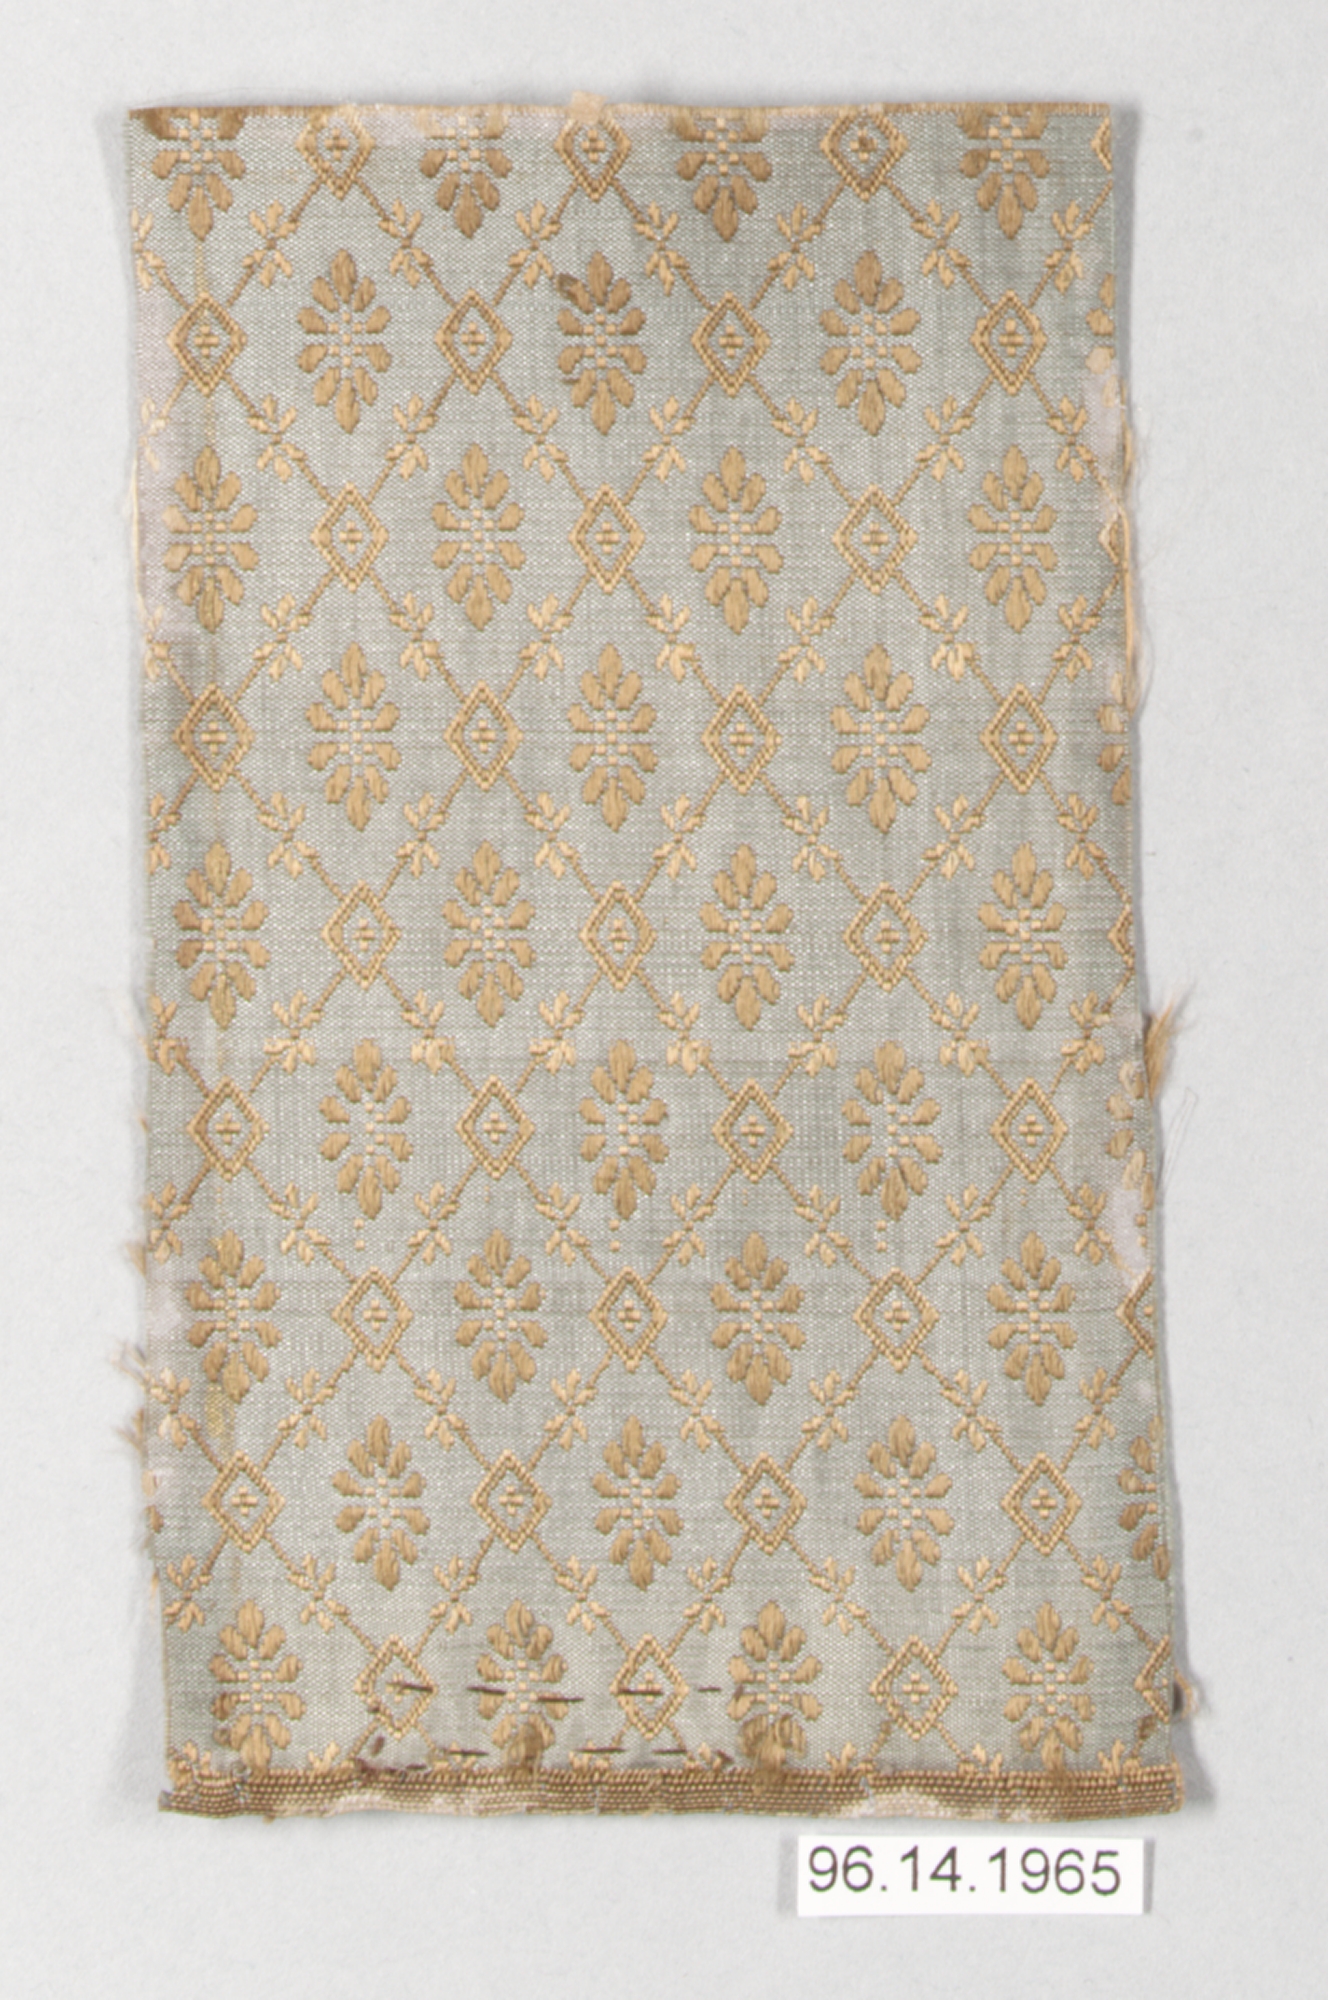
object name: piece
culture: japanese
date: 1701-1800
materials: silk